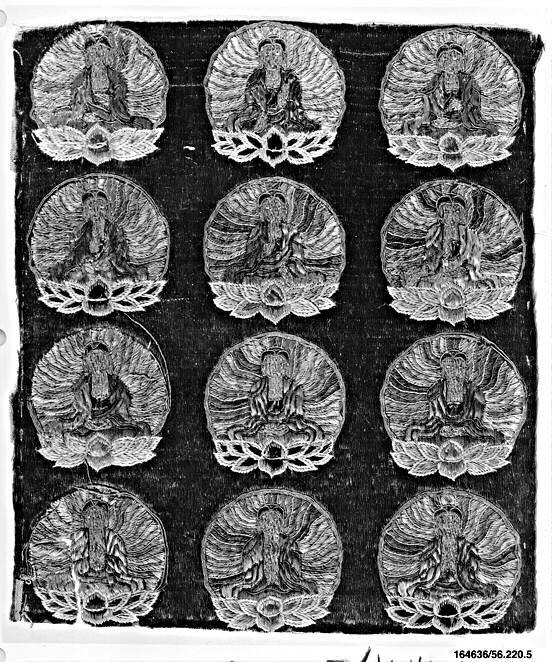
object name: panel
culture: chinese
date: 1368-1644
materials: metal thread, silk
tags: buddha